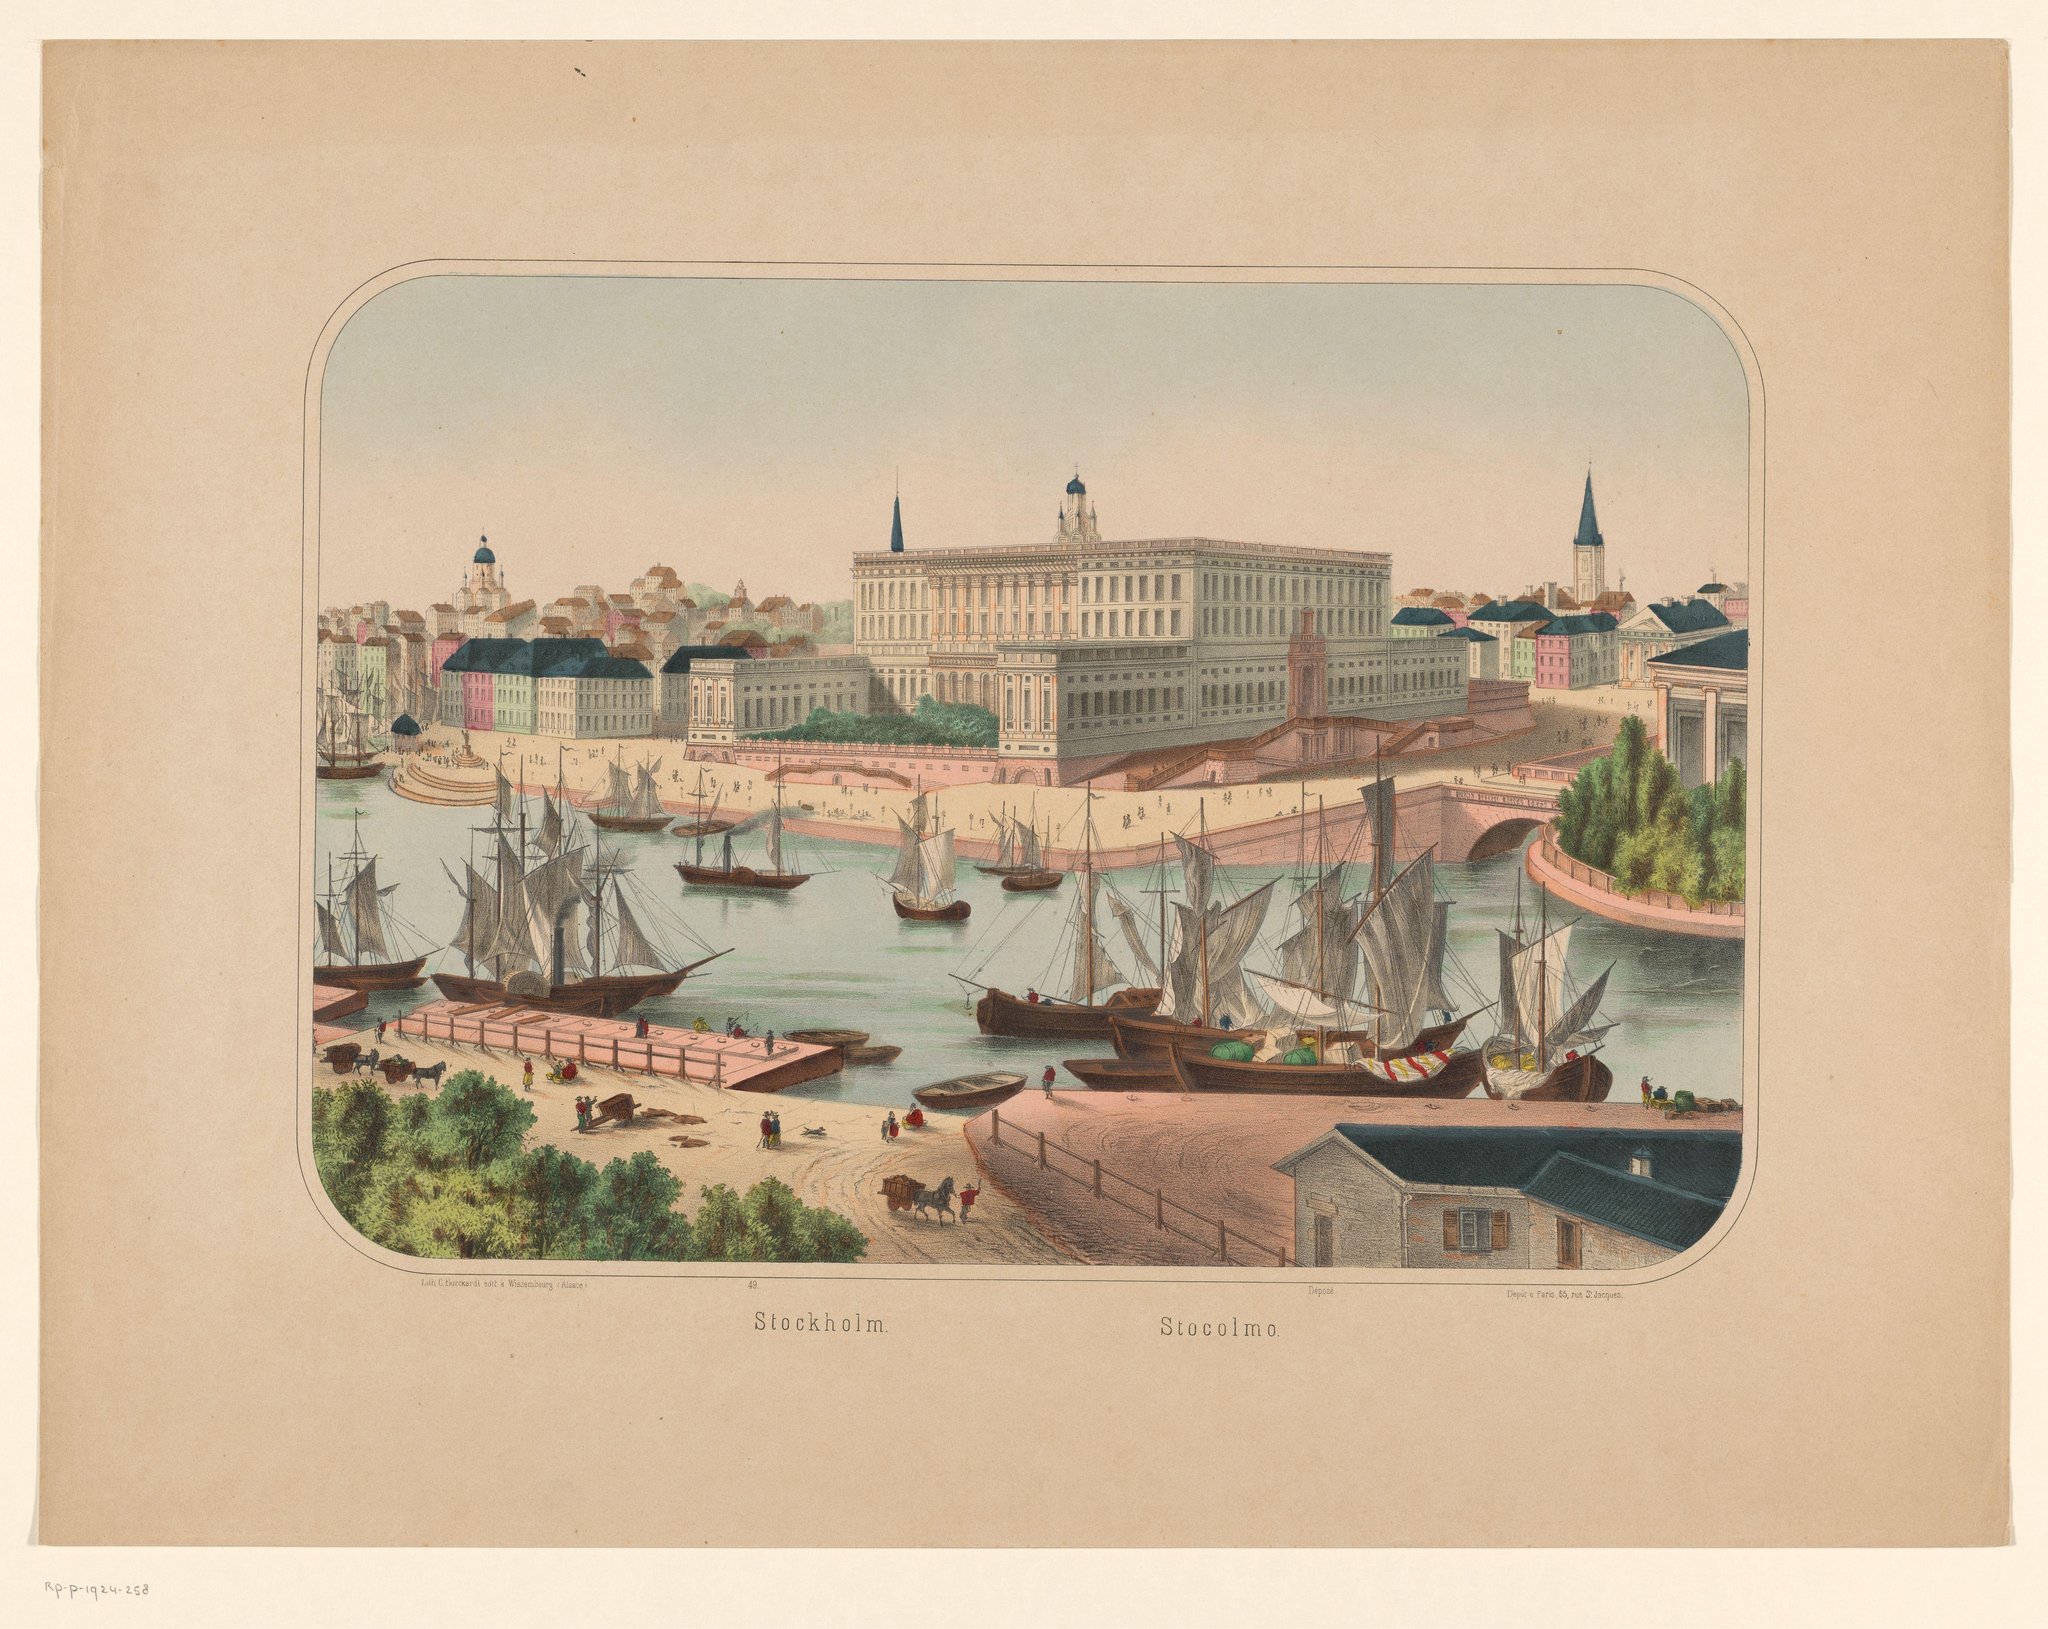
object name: print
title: Stockholm / Stocolmo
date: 1870-1889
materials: paper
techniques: lithograph, hand coloring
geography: wissembourg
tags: palace, prospect of city, town panorama, silhouette of city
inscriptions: : ‘Déposé’, collector's mark: Lugt 2233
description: Gezicht op Stockholm, met centraal het Koninklijk Paleis.